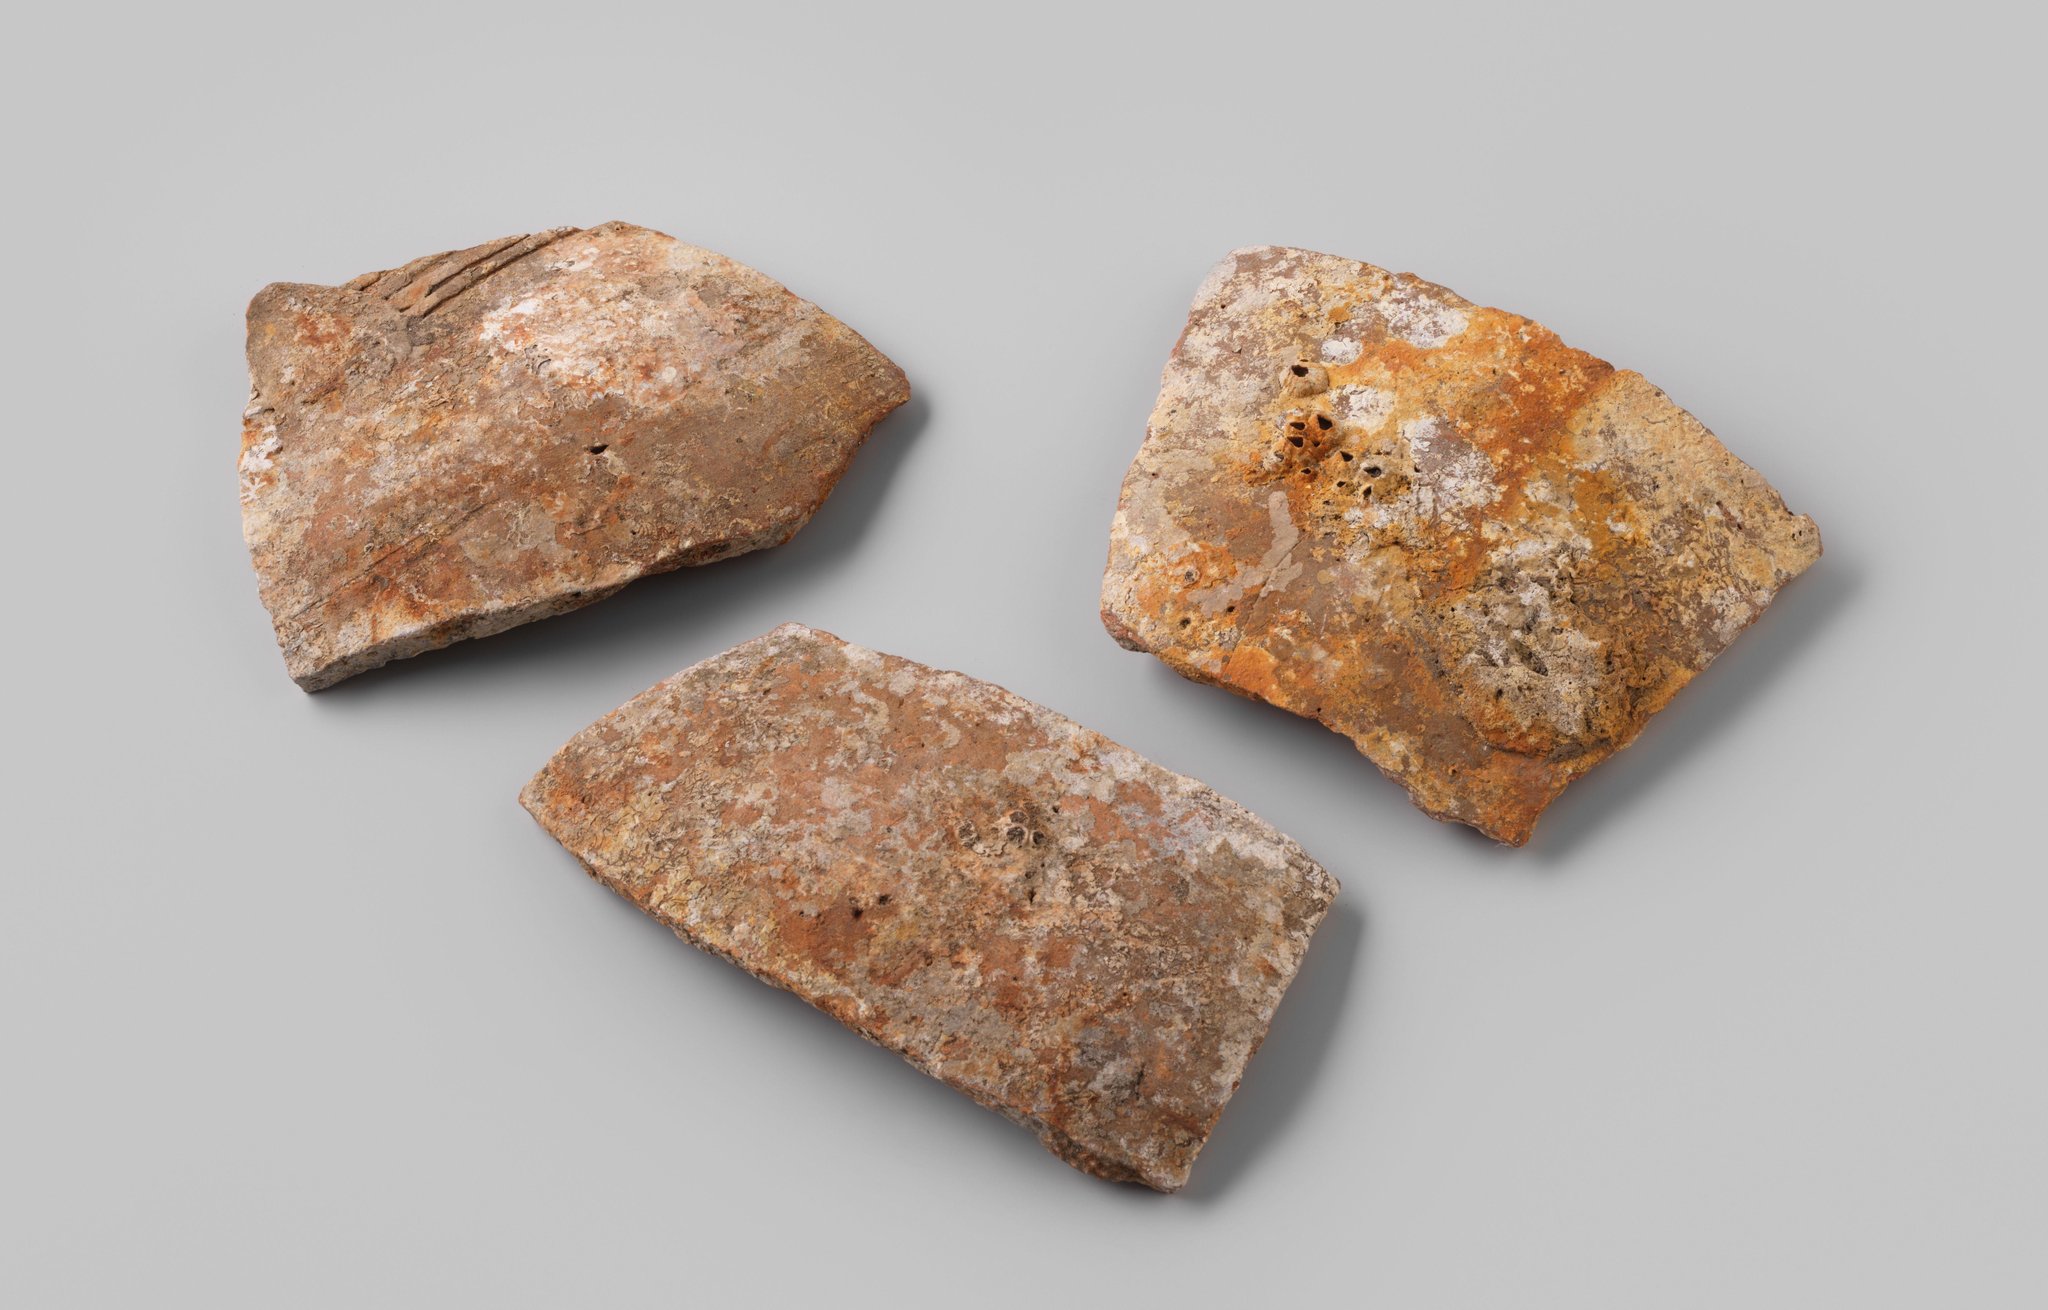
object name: martavaan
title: Scherven van martavanen uit het wrak van de Oostindiëvaarder Hollandia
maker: Anonymous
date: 1700-1743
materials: porcelain, stoneware